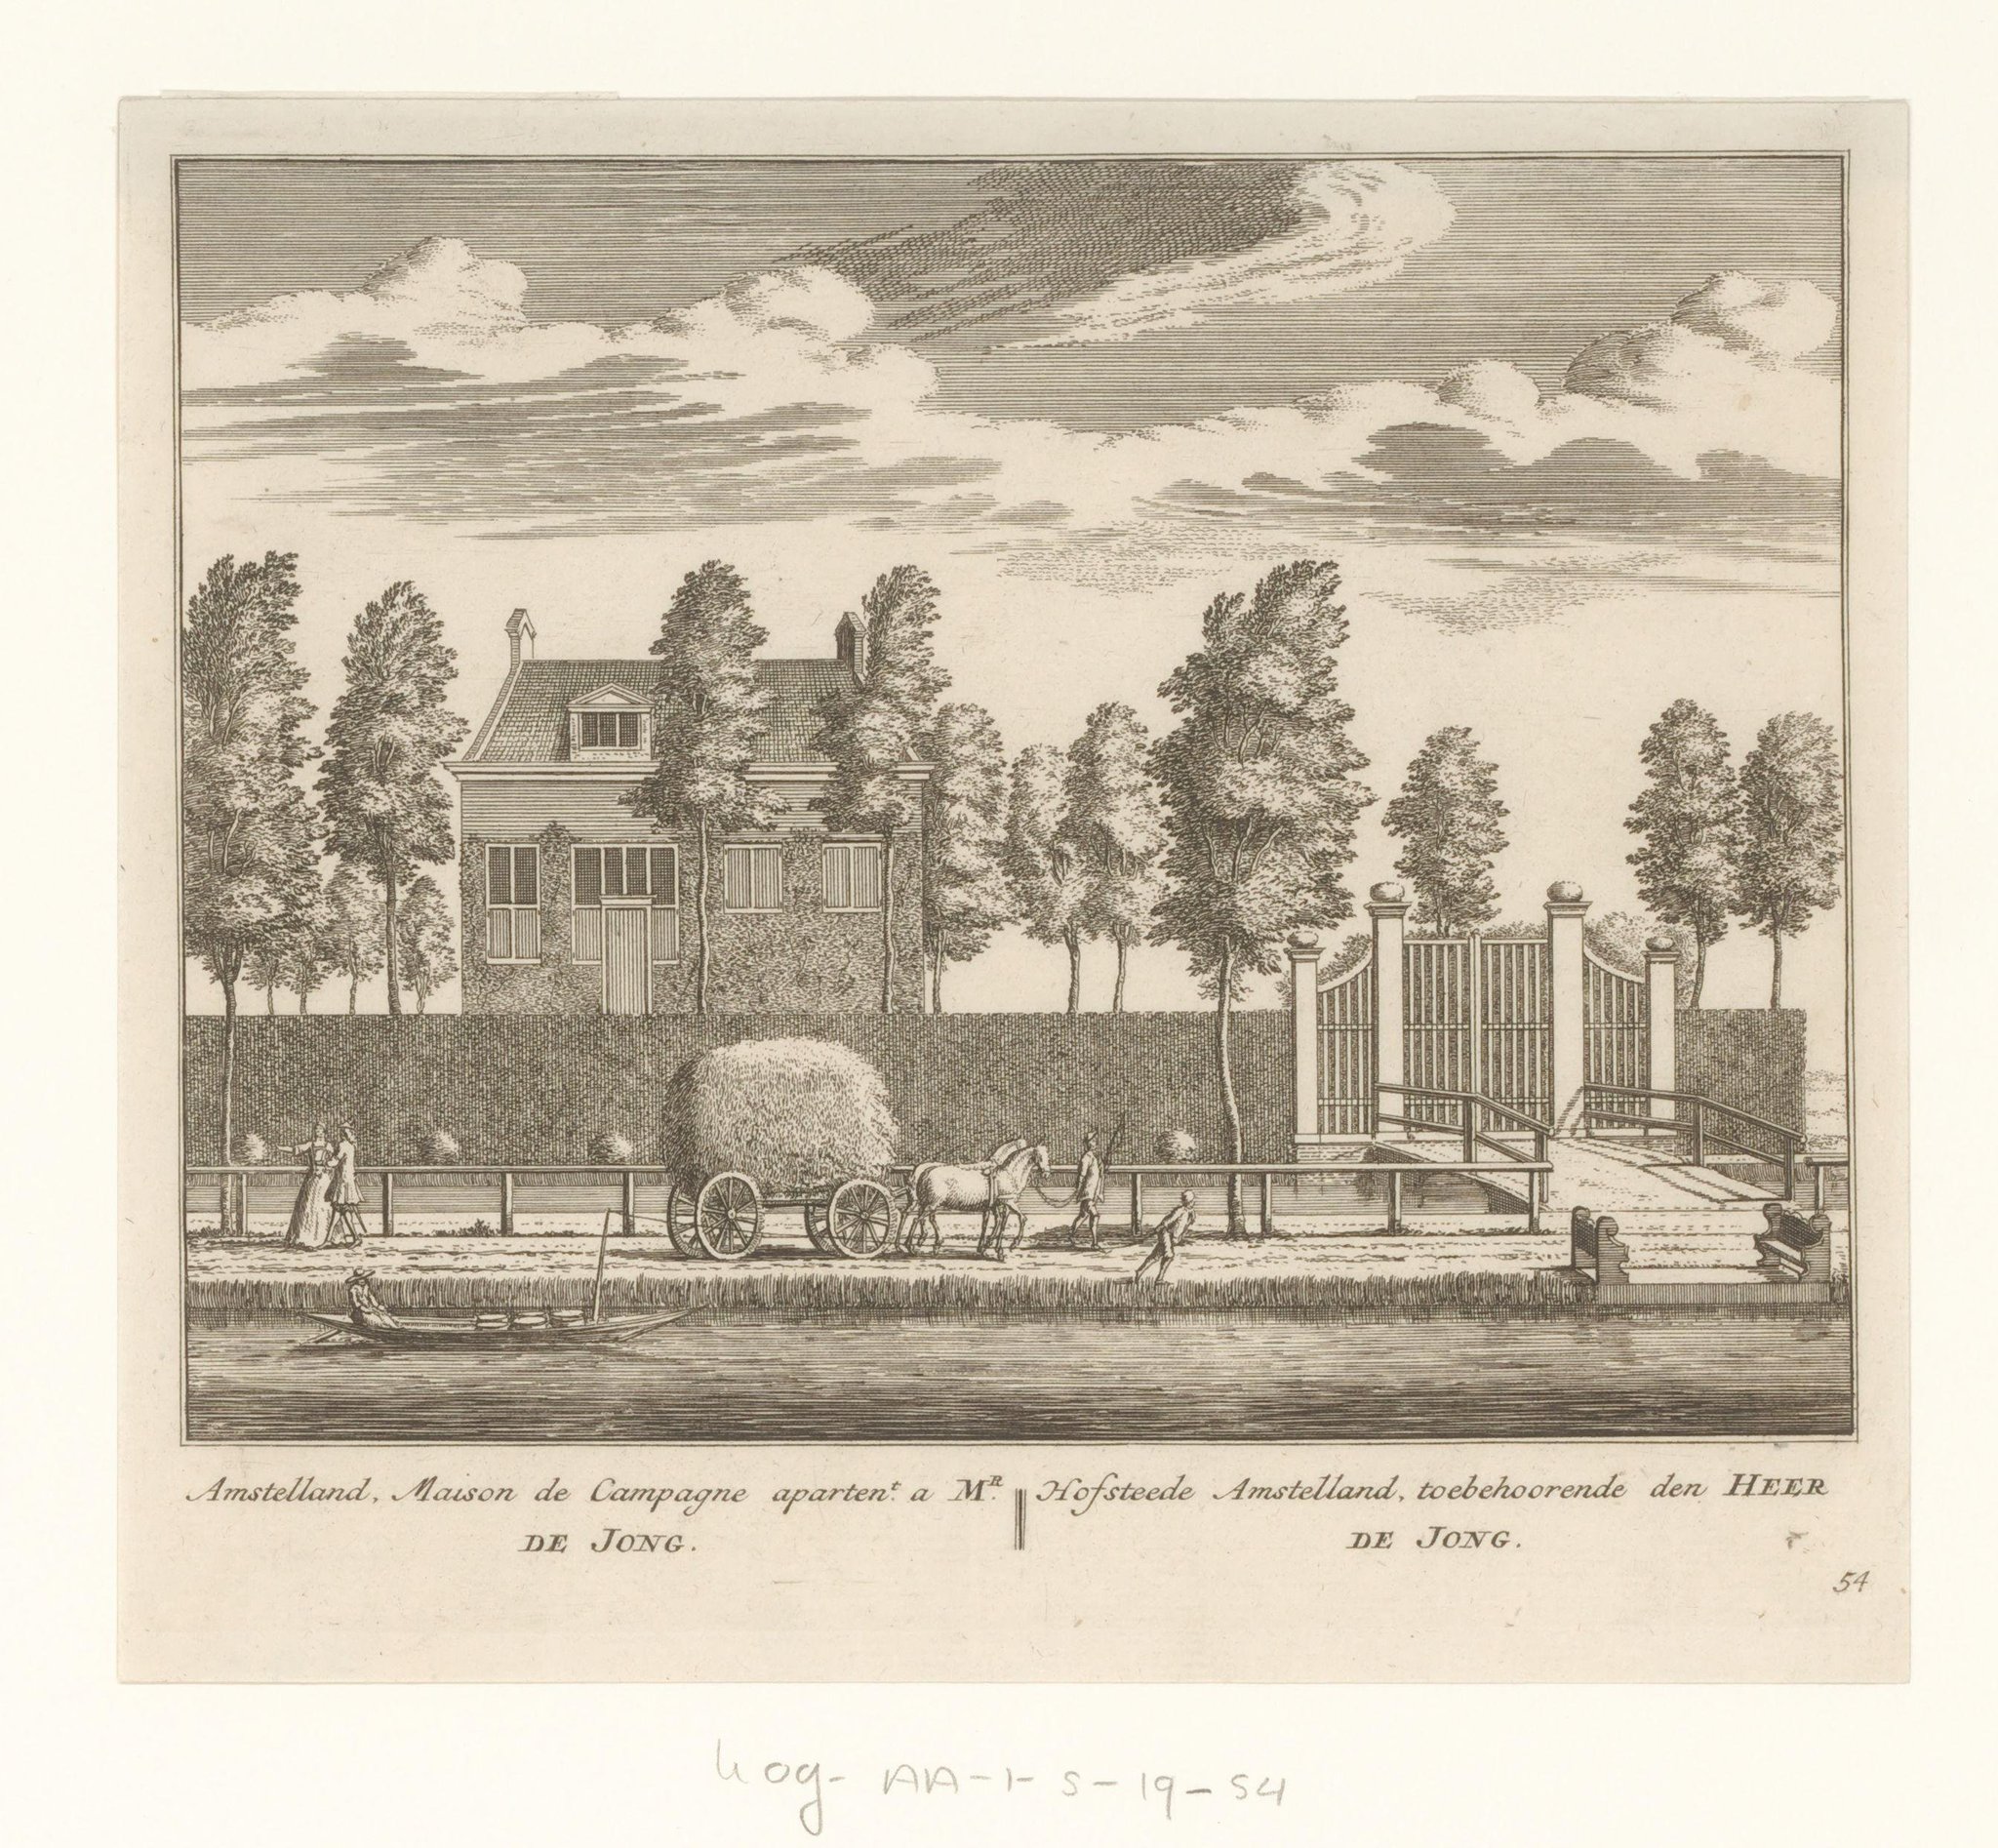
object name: print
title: Gezicht op buitenplaats Amstelland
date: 1730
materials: paper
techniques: etching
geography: amsterdam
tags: city-view in general; 'veduta', river, rural housing, e.g. country-house, villa, cottage, gate, entrance, boat propelled by man or animal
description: Prent waarschijnlijk uit: Tijsens, Gijsbert. Hollands Arcadia, of de vermaarde rivier den Amstel (...) naar 't léven getekend en in 't ligt gebragt door Abraham Rademaker (...). Amsterdam: Leonardus Schenk, 1730.